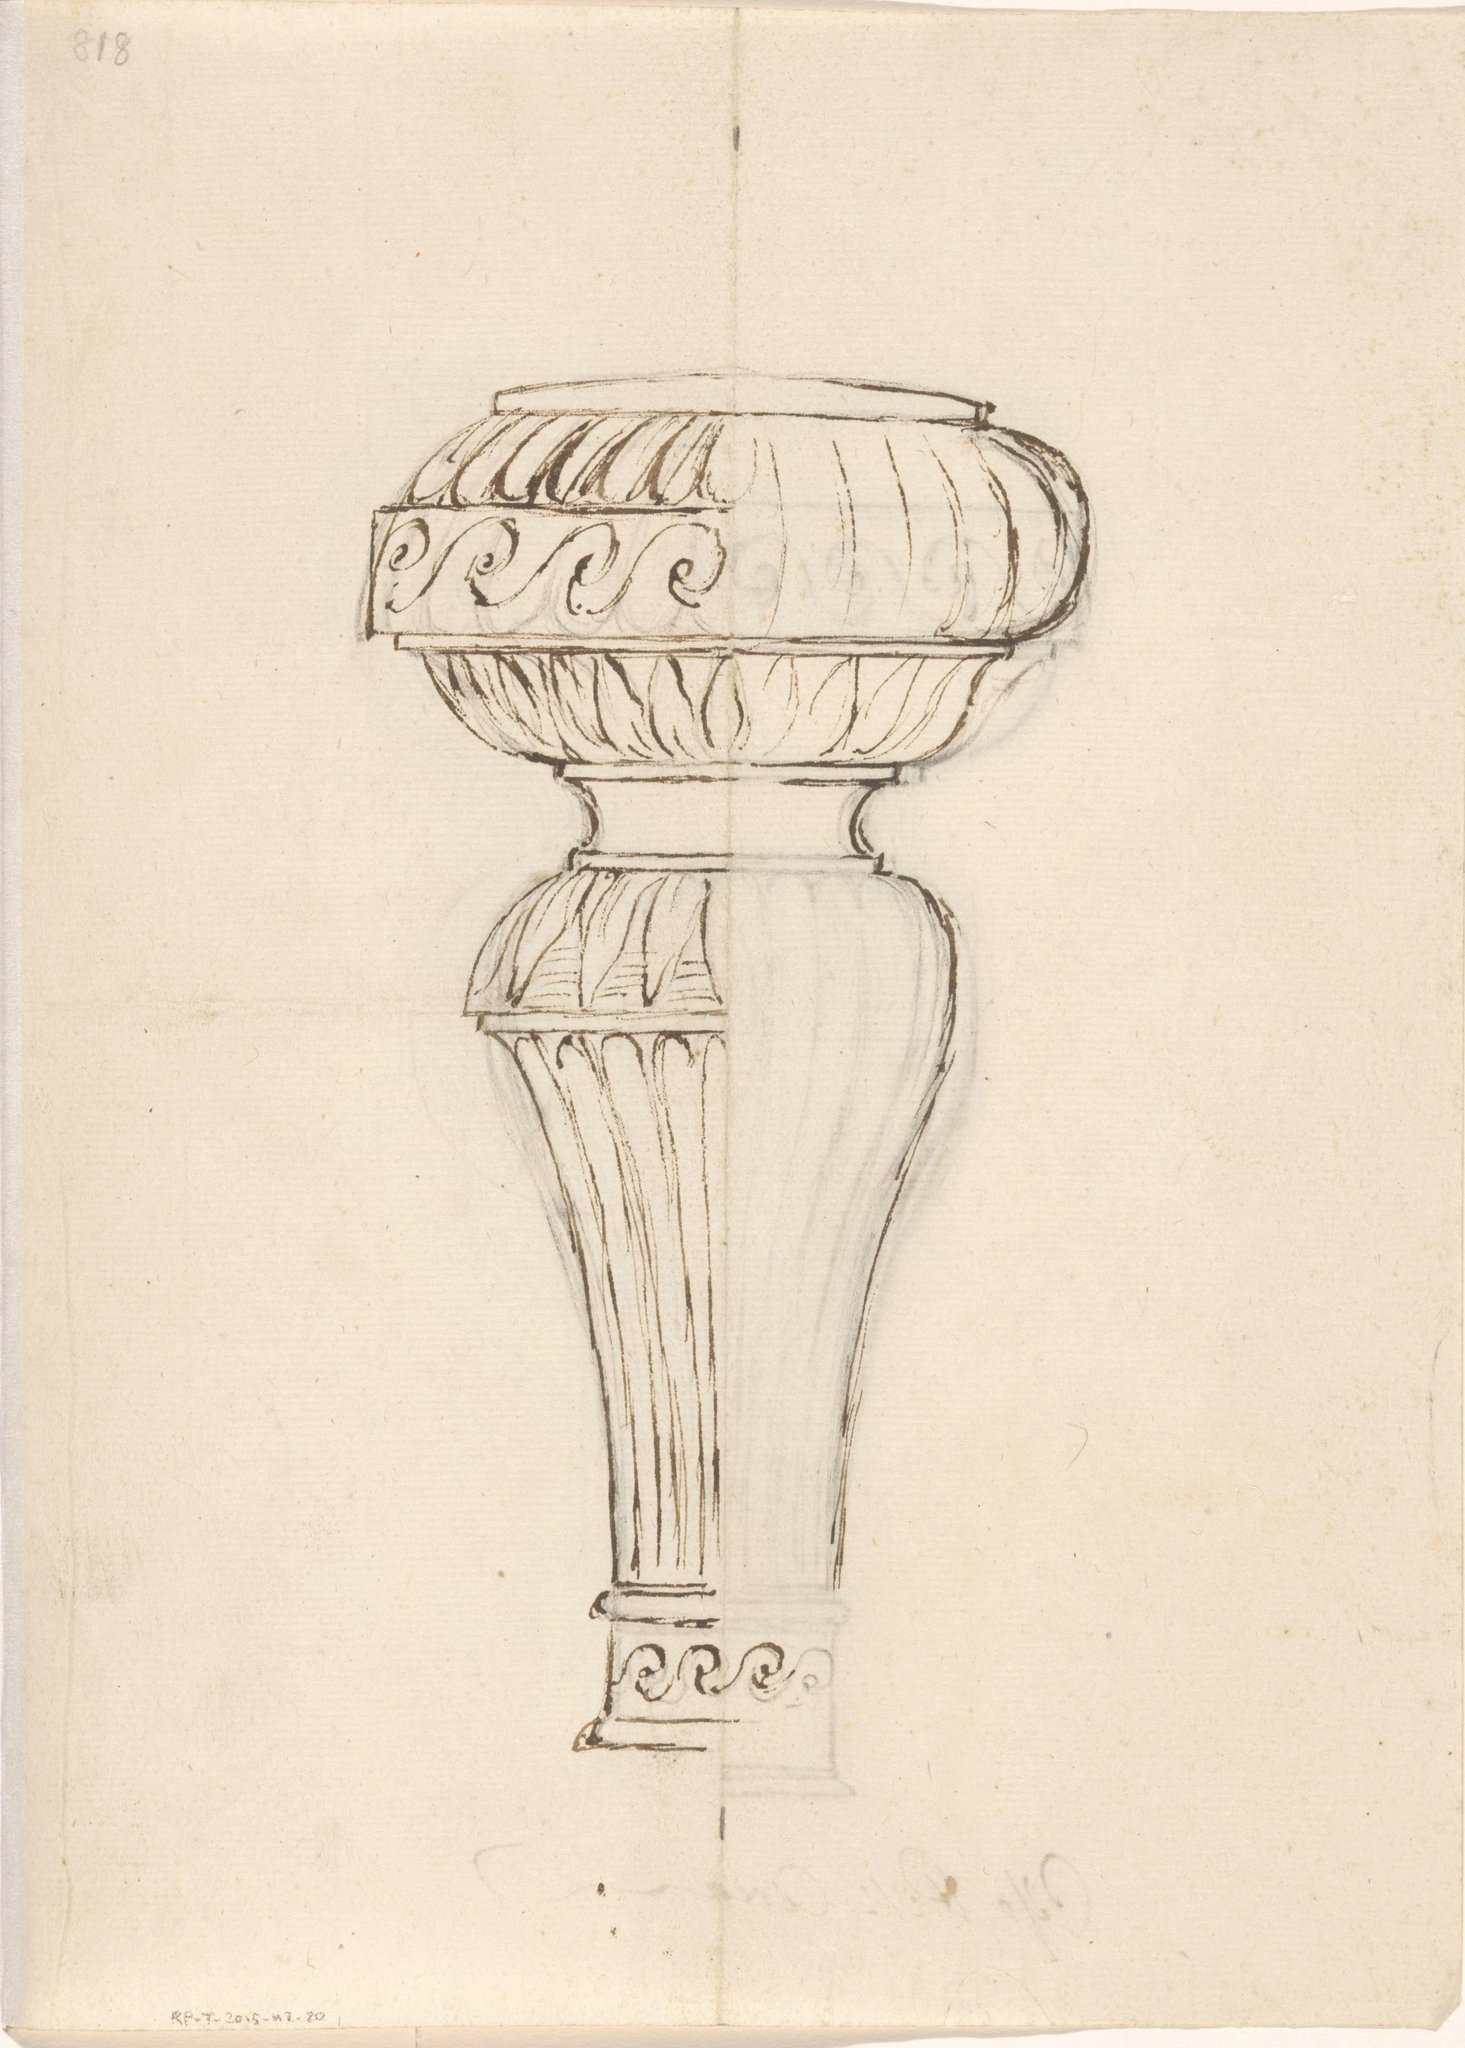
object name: design drawing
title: Ontwerp voor de bekroning van een staf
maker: luigi valadier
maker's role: draughtsman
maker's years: 1726-1785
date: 1760-1780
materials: graphite, ink, paper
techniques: pen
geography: rome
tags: sceptre, staff (symbol of sovereignty), walking-stick, staff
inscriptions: inscription: ‘Ontwerp voor de bekroning van een staf, de linkerhelft met meer details dan de rechterhelft.’, watermark, inscription: ‘Peso P: 12 [?] Circa’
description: Ontwerp voor de bekroning van een staf, de rechterhelft met andere details dan de linkerhelft.